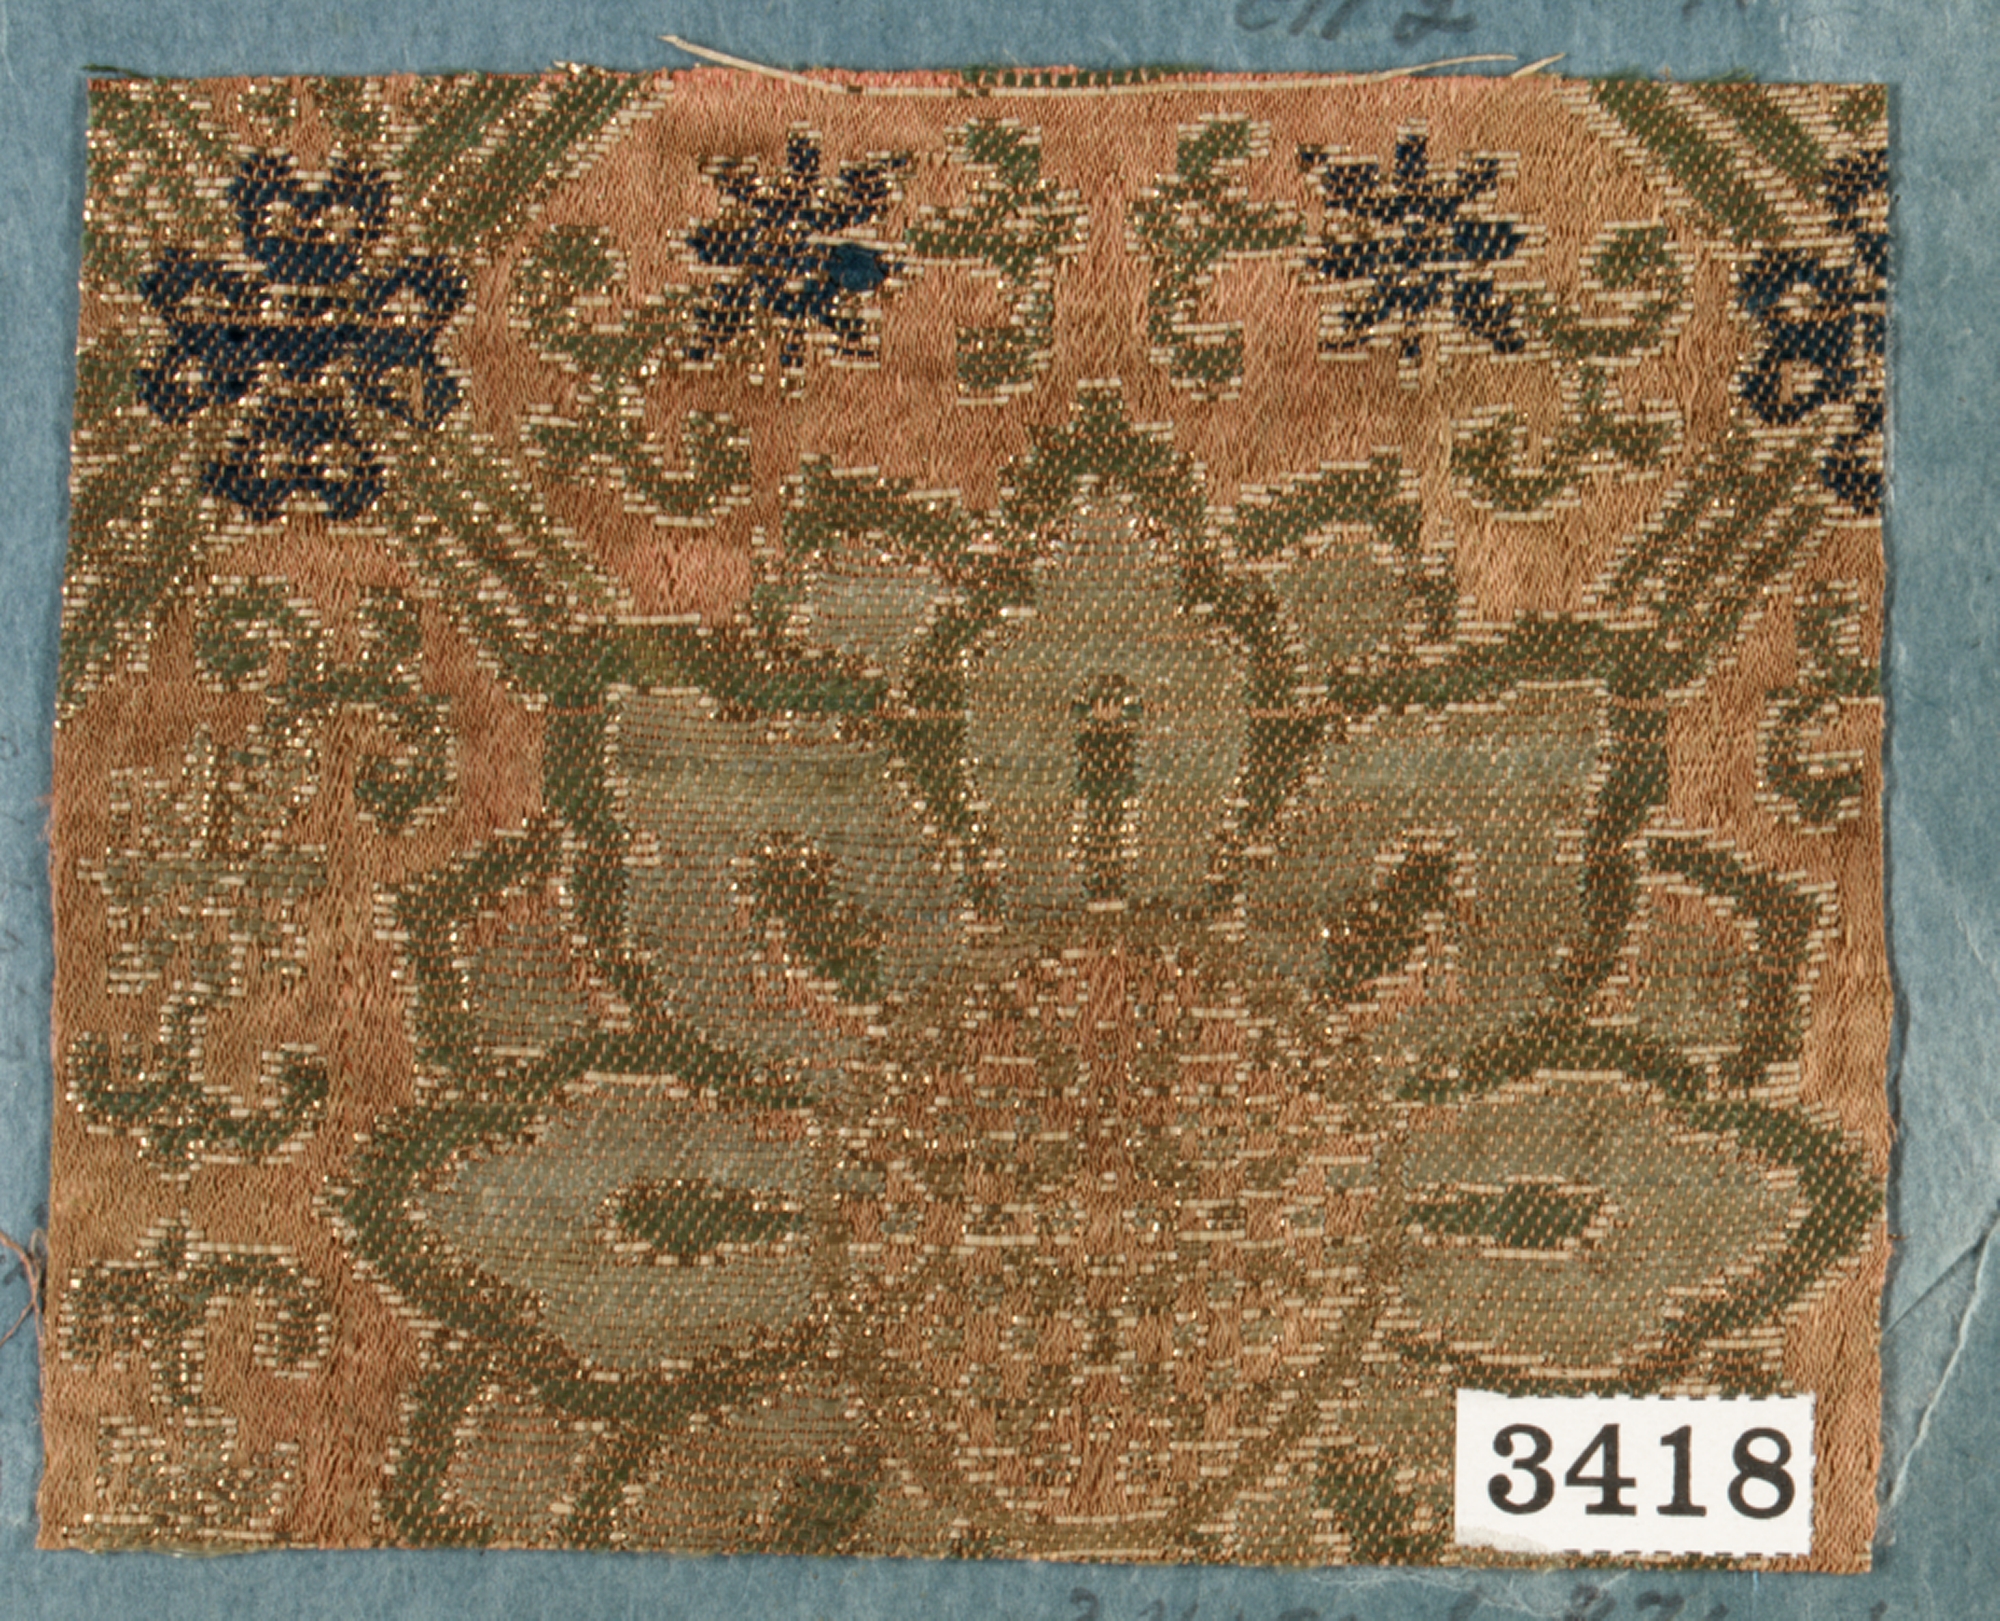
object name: textile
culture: japanese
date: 1801-1900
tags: flowers